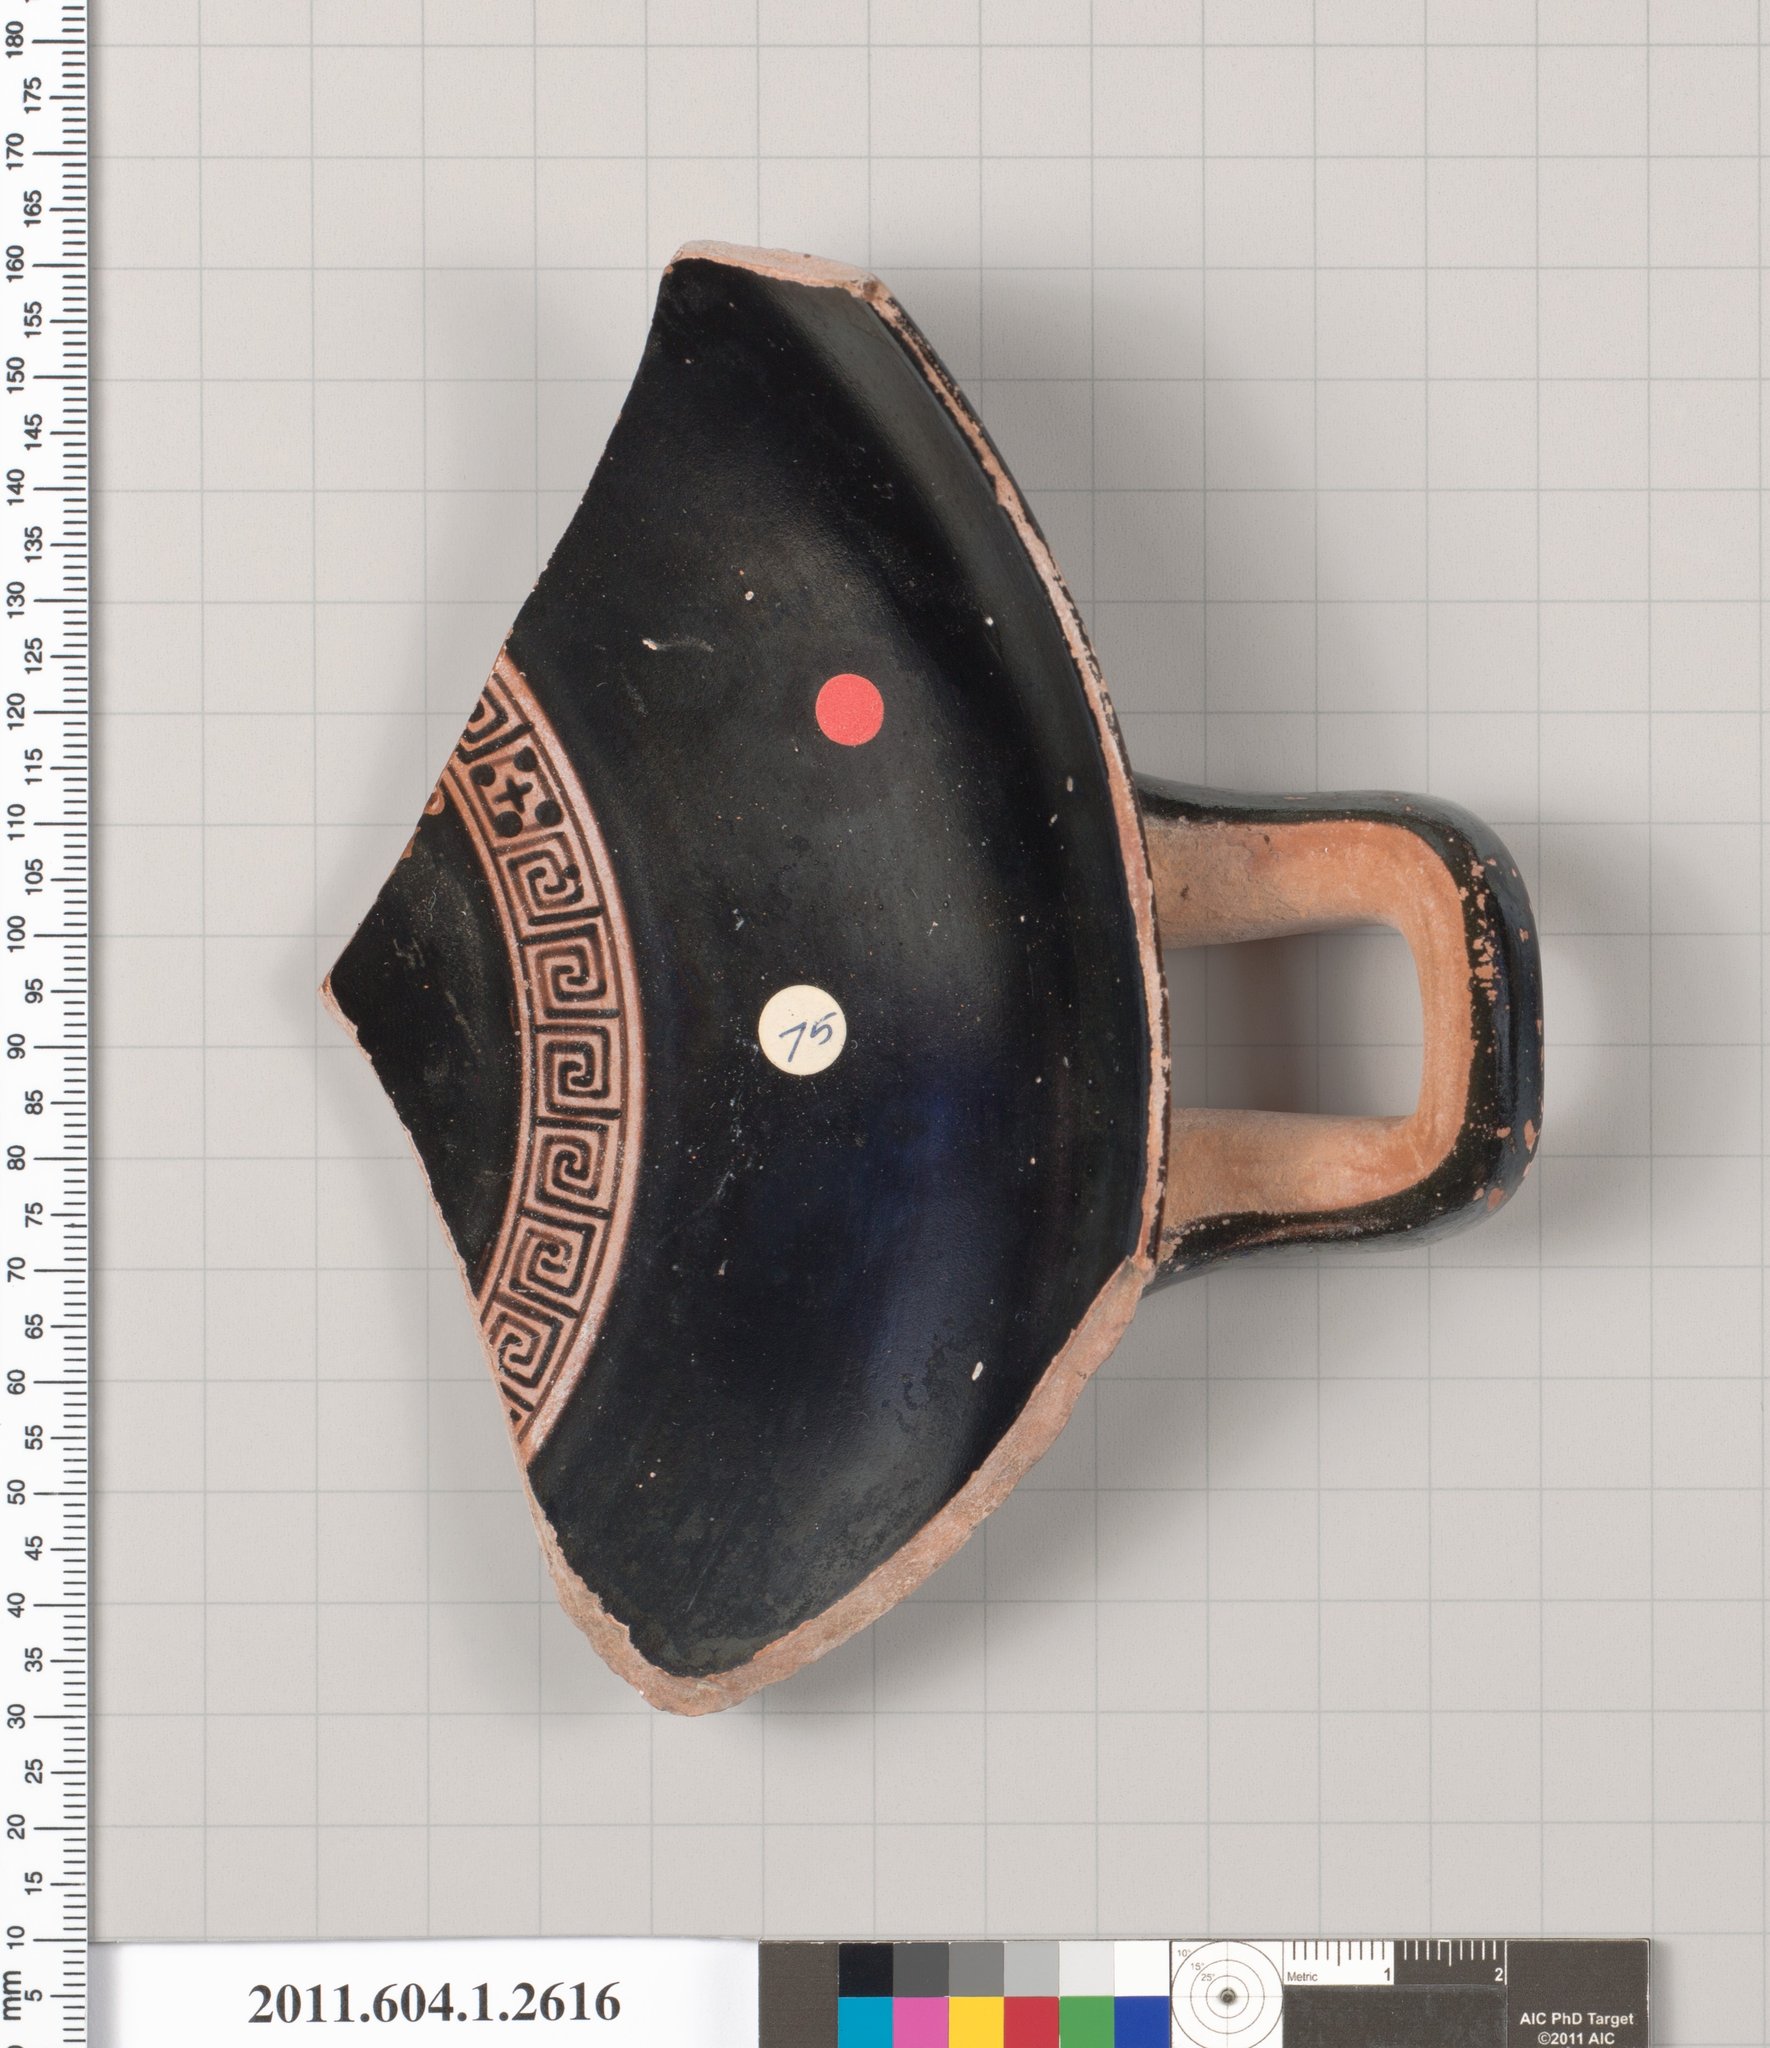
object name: kylix fragment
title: Terracotta fragment of a kylix (drinking cup)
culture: greek, attic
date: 500-480 BCE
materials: terracotta